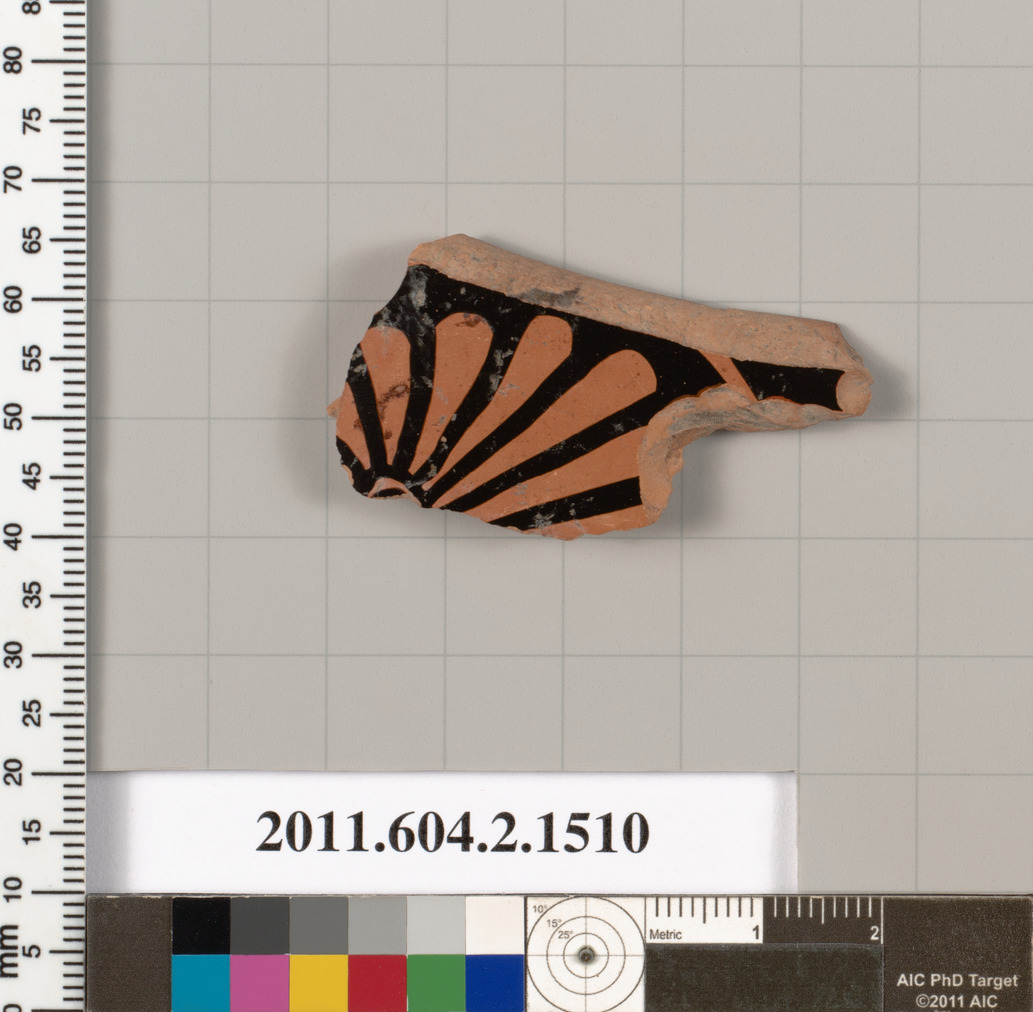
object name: skyphos fragment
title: Terracotta fragment of a skyphos (deep drinking cup)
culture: greek, attic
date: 460-440 BCE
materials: terracotta